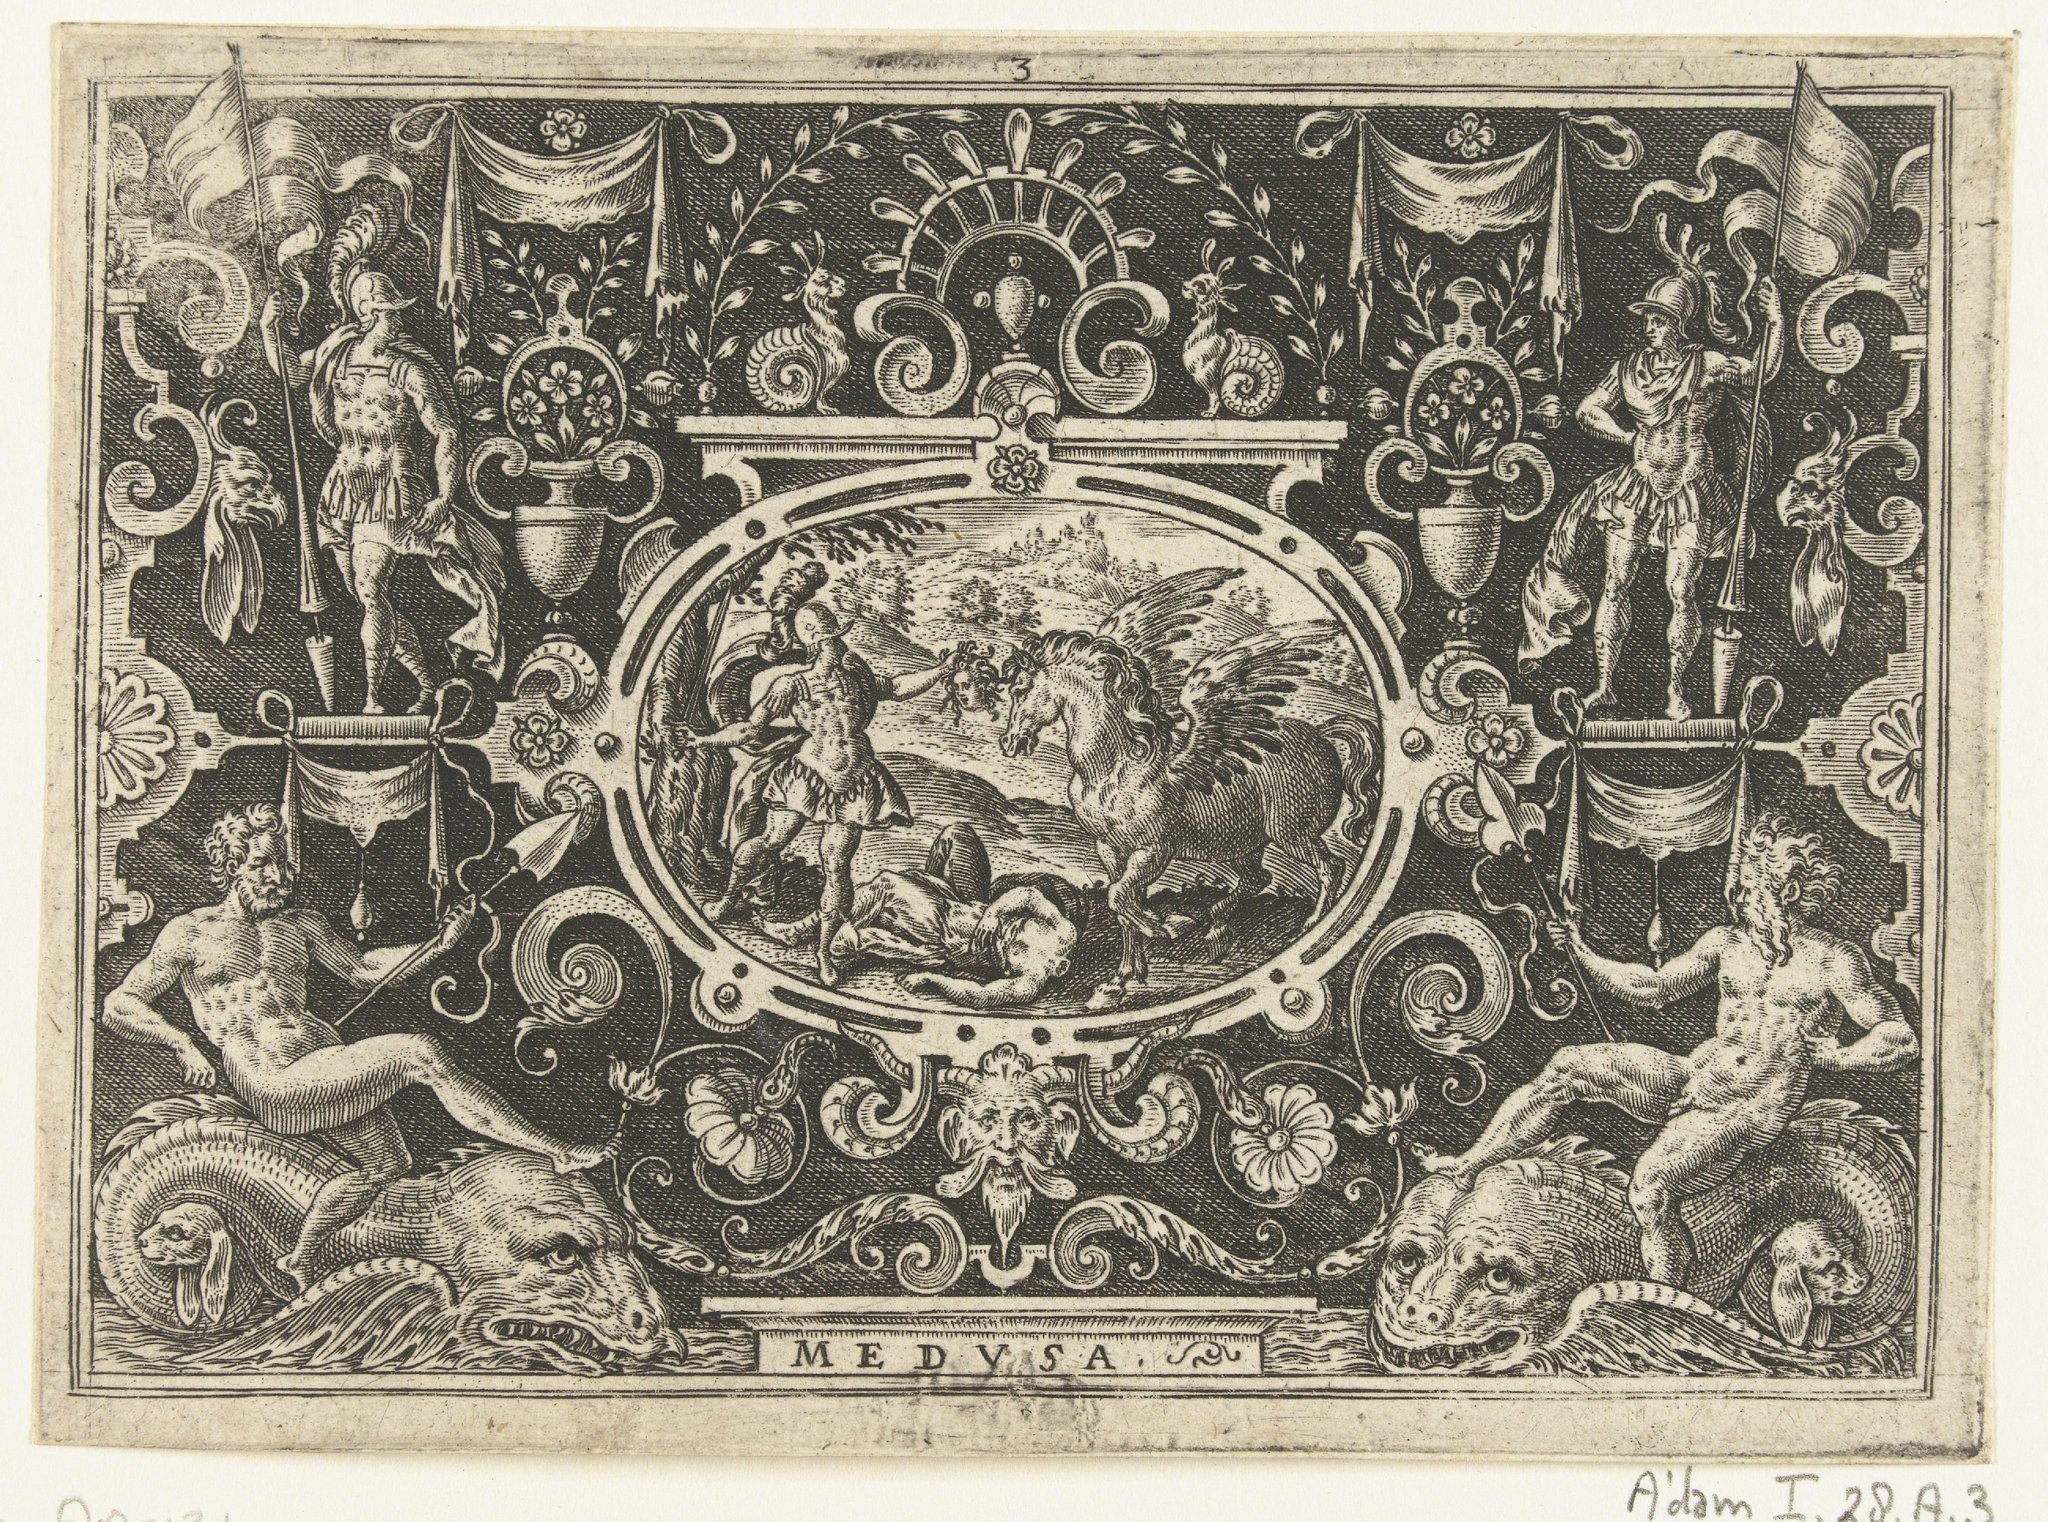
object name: print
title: Perseus met het hoofd van Medusa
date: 1584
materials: paper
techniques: engraving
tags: ornament ~ grotesque, fabulous animals ~ fishes, vase ~ ornament, ornament ~ cartouche, perseus beheading medusa, with pegasus, and possibly also chrysaor, the warrior with the golden sword, springing from the blood of medusa's head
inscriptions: title: ‘MEDUSA’, number: ‘3’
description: Ovaal cartouche in omlijsting van grotesken, tegen gearceerde achtergrond. Perseus staat in een landschap en houdt het hoofd van Medusa omhoog. Haar lijk ligt aan zijn voeten. Rechts Pegasus. In de omlijsting linksonder en rechtsonder een man op een zeemonster. Daarboven een krijgsman met vaandel.